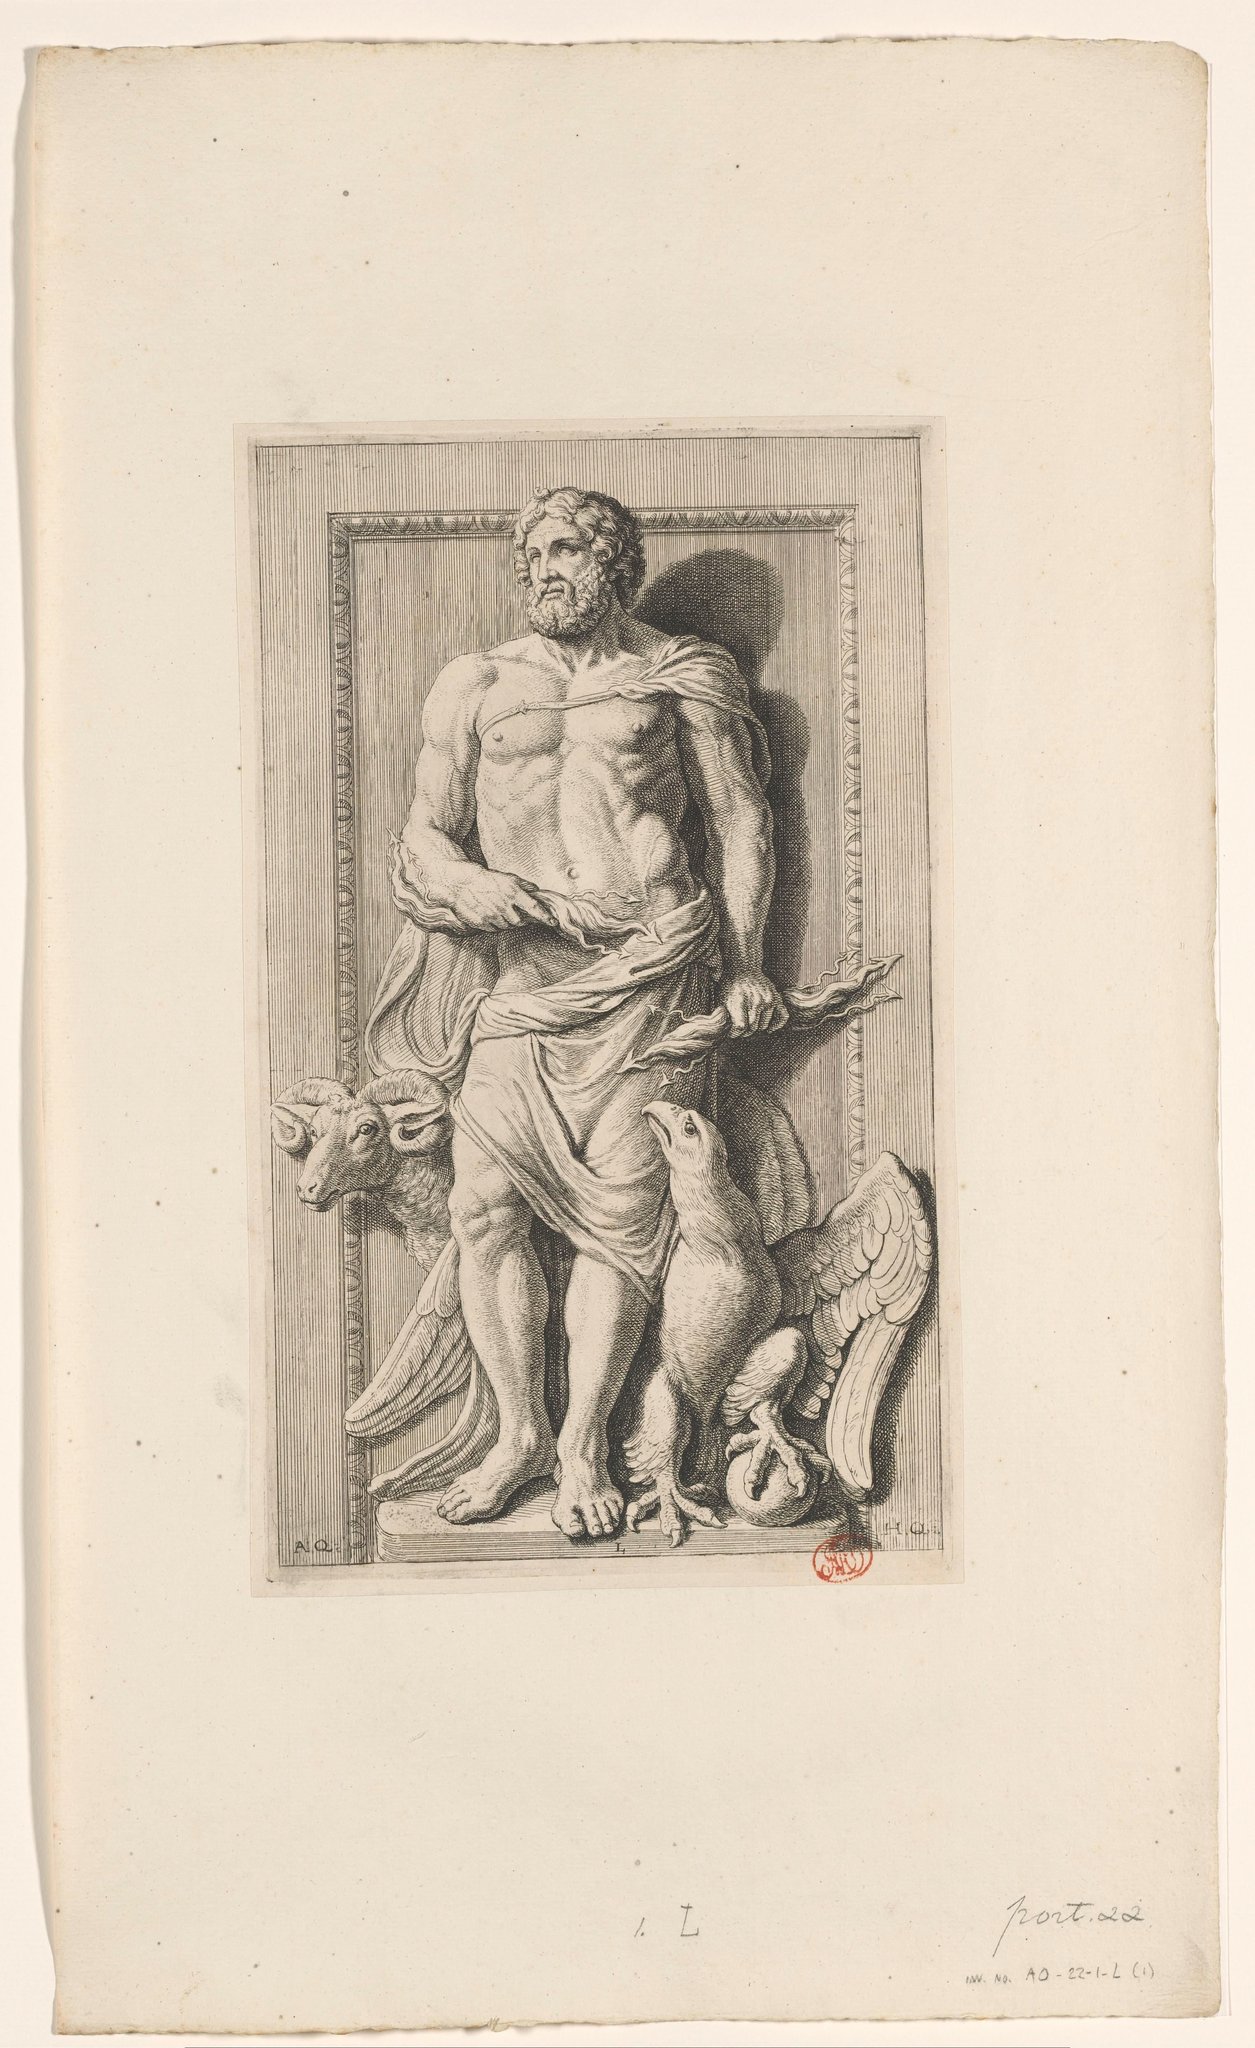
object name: print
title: Beeld van Jupiter in de zuidelijke galerij van het Stadhuis op de Dam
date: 1655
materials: paper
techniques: engraving, etching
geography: amsterdam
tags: (story of) jupiter (zeus), attributes of jupiter: eagle, attributes of jupiter: thunderbolt, attributes of jupiter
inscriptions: collector's mark: Lugt 195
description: Prent gebruikt in: Prima pars. Praecipuarum effigierum ac ornamentorum, amplissimae Curiae Amstelrodamensis (…) / Het eerste deel. Van de voornaemste Statuen ende Ciraten, vant konstijck Stadhuys van Amstelredam, tmeeste in marmer gemaeckt, door Artus Quellinus, Beelthouwer der voorseyde Stadt / La Premier Partie. De plusieurs Figures et ornements, de la Maison de Ville d'Amsterdam (…). Amsterdam: Artus Quellinus (I), 1655. Zie RP-P-AO-22-1-1 voor bijhorende titelpagina. Zie RP-P-AO-22-1-2 voor bijhorend register. Zie RP-P-AO-22-1A, RP-P-AO-22-1B, RP-P-AO-22-1C, RP-P-AO-22-1D-1, RP-P-AO-22-1D-2, RP-P-AO-22-1E, RP-P-AO-22-1F, RP-P-AO-22-1G, RP-P-AO-22-1H, RP-P-AO-22-1I, RP-P-AO-22-1K-1, RP-P-AO-22-1K-2, RP-P-AO-22-1K-3, RP-P-AO-22-1K-4, RP-P-AO-22-1K-5, RP-P-AO-22-1L-2, RP-P-AO-22-1M-1, RP-P-AO-22-1M-2, RP-P-AO-22-1N-1, RP-P-AO-22-1N-2, RP-P-AO-22-1N-3, RP-P-AO-22-1N-4, RP-P-AO-22-1N-5, RP-P-AO-22-1O-1, RP-P-AO-22-1O-2, RP-P-AO-22-1O-3, RP-P-AO-22-1O-4, RP-P-AO-22-1P-1, RP-P-AO-22-1P-2, RP-P-AO-22-1P-3, RP-P-AO-22-1P-4, RP-P-AO-22-1Q-1, RP-P-AO-22-1Q-2, RP-P-AO-22-1Q-3, RP-P-AO-22-1Q-4, RP-P-AO-22-1R-1, RP-P-AO-22-1R-2, RP-P-AO-22-1R-3, RP-P-AO-22-1R-4, RP-P-AO-22-1R-5, RP-P-AO-22-1S-1, RP-P-AO-22-1S-2, RP-P-AO-22-1S-3, RP-P-AO-22-1S-4, RP-P-AO-22-1S-5, RP-P-AO-22-1T-1 en RP-P-AO-22-1T-2 voor andere prenten uit deze publicatie. Zelfde staat van prent ook gebruikt in: Prima pars. Praecipuarum effigierum ac ornamentorum, amplissimae Curiae Amstelrodamensis (…) / Het eerste deel. Van de voornaemste Statuen ende Ciraten, vant konstijck Stadhuys van Amstelredam, tmeeste in marmer gemaeckt, door Artus Quellinus, Beelthouwer der voorseyde Stadt / La Premier Partie. De plusieurs Figures et ornements, de la Maison de Ville d'Amsterdam (…). Amsterdam: Frederik de Wit, 1665. Latere staat van prent ook gebruikt in: Architecture peinture et sculpture de la Maison de Ville d'Amsterdam, representee en CIX. figures en taille-douce (…). Amsterdam: David Mortier, 1719. En in: Architecture peinture et sculpture de la Maison de Ville d'Amsterdam, representee en CIX. figures en taille-douce (…). Amsterdam: Gerard Valck, 1719. En in: Bouw schilder en beeldhouwkonst, van het Stadhuis te Amsteldam, vertoont in CIX figuuren (…). Amsterdam: Covens & Mortier & Covens Jr., s.a. (1774-1783). Zie BK-AM-51-16 voor model van het beeld.